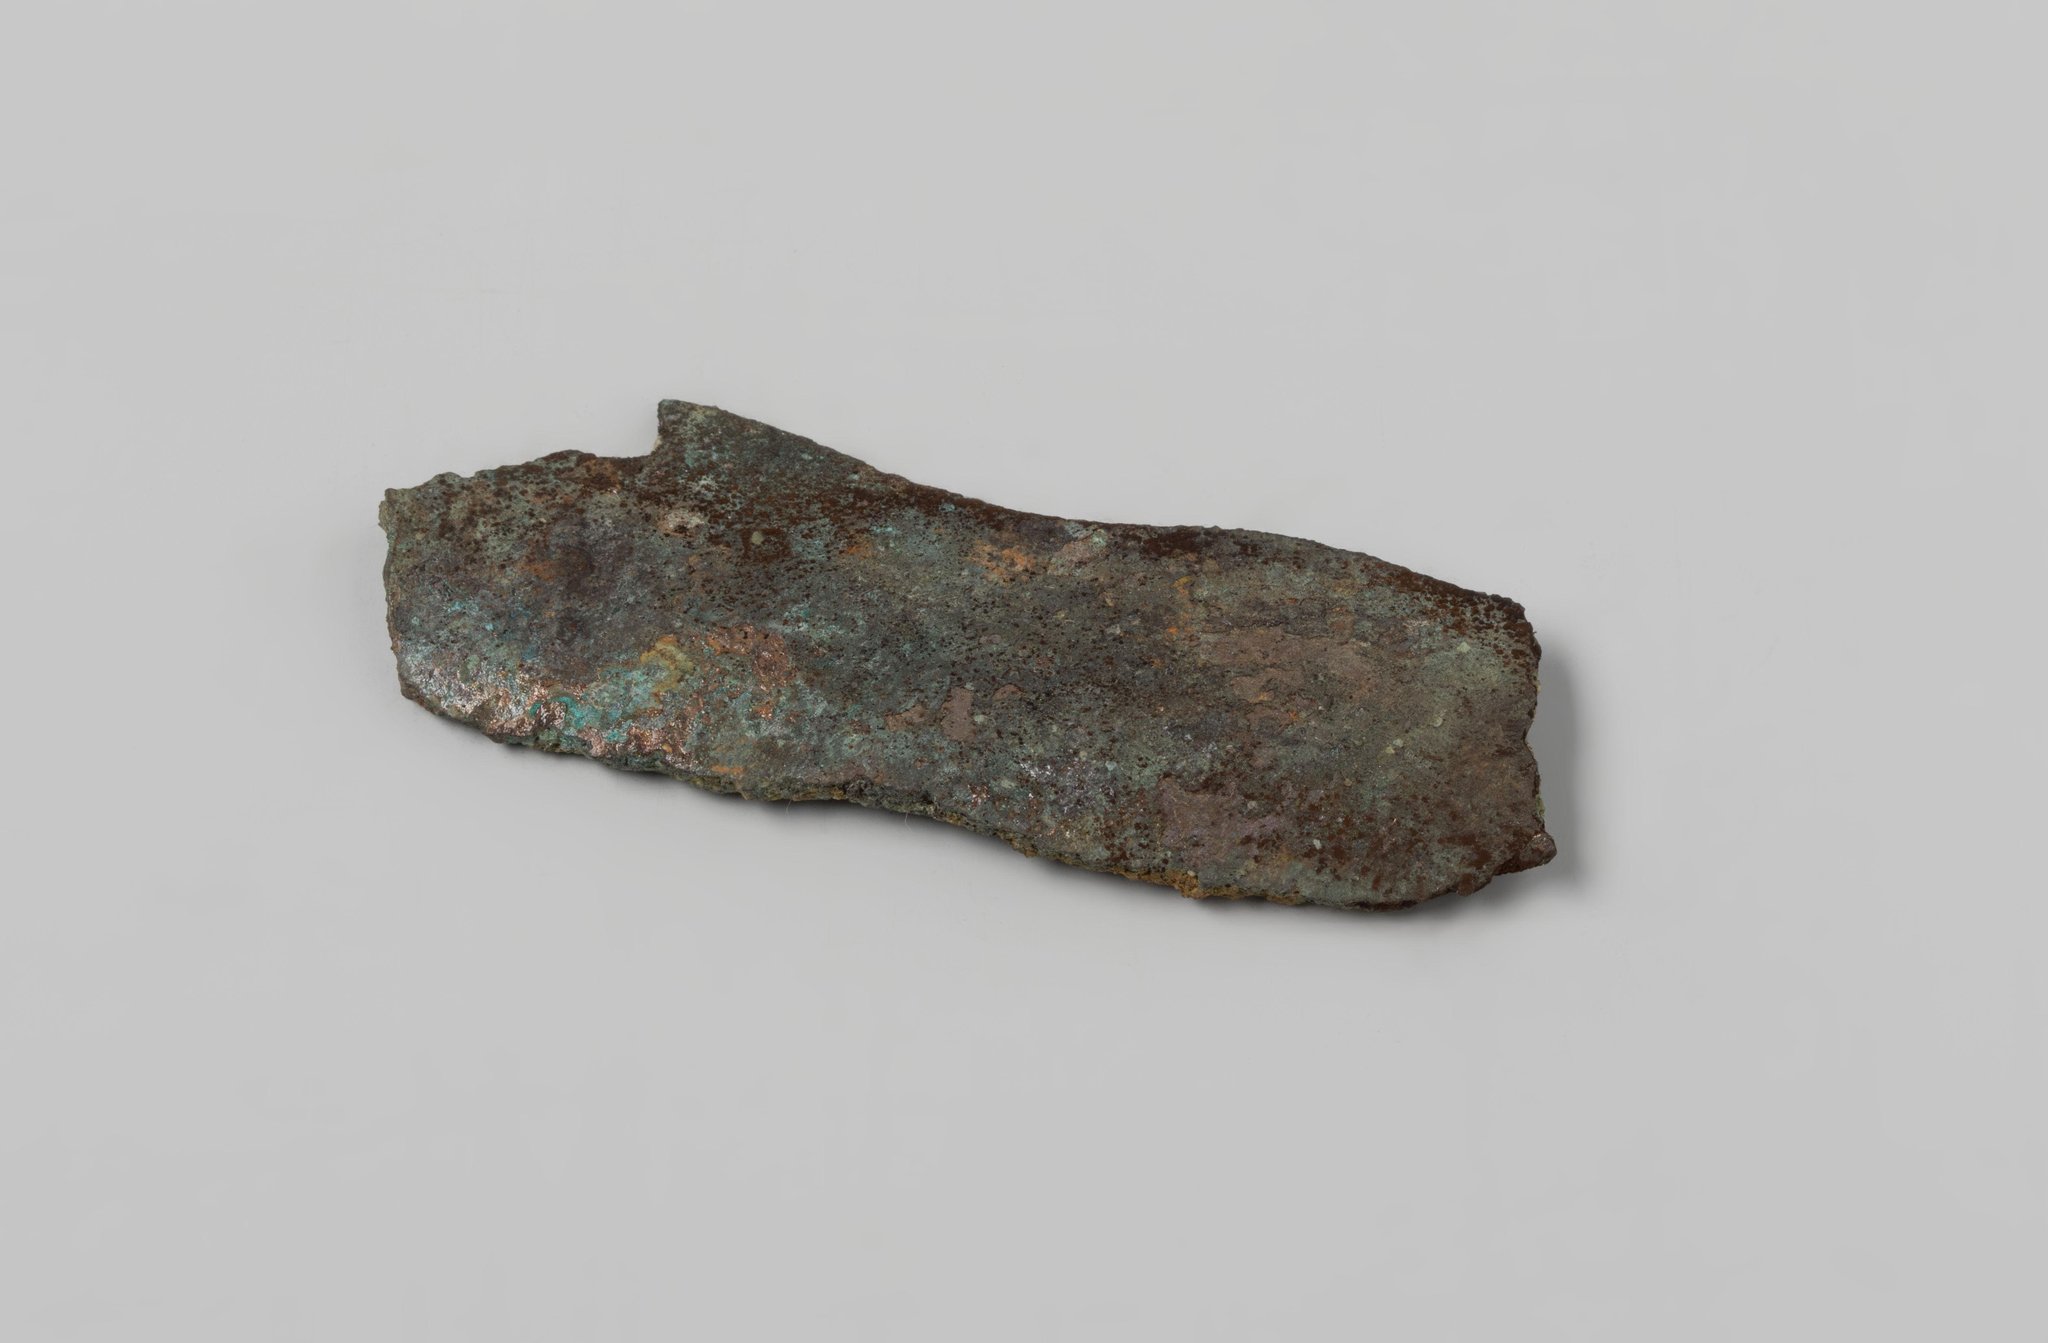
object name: fragment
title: Fragment koper uit het wrak van de Oost-Indiëvaarder Hollandia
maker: Anonymous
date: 1700-1743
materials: copper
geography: netherlands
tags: verenigde oostindische compagnie, hollandia (schip), annet